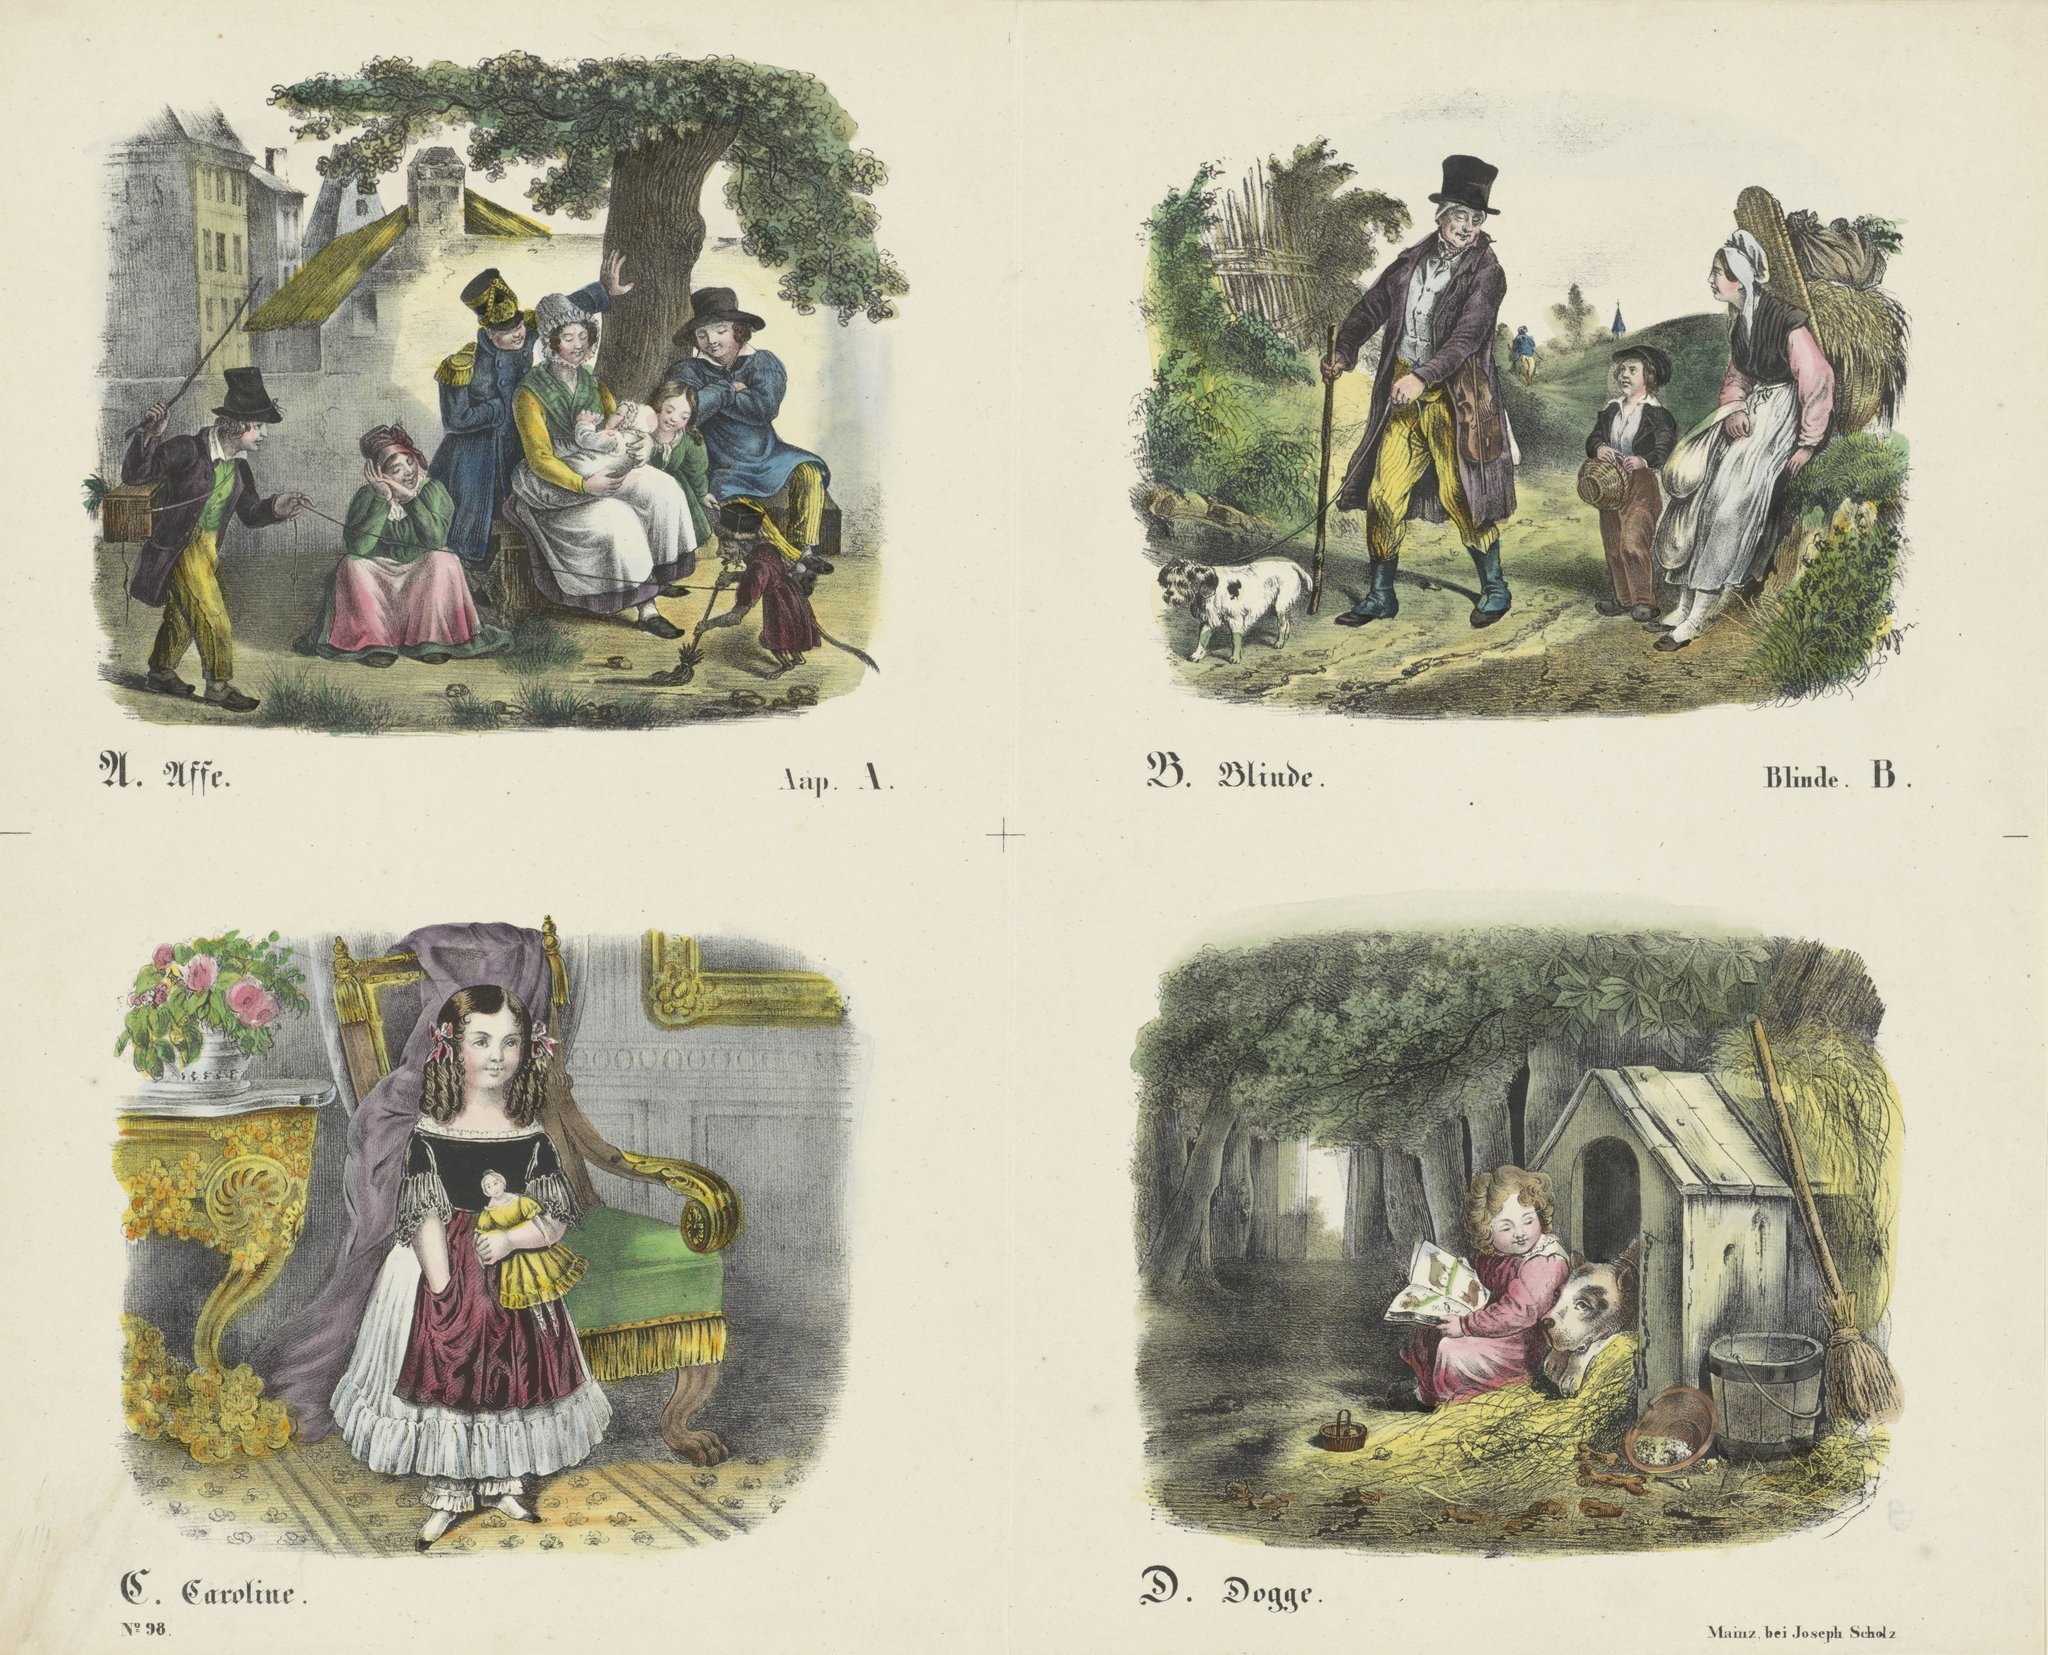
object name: popular print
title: Bilder A B C / Buch. / Prenten A B / Boek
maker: Anonymous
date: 1829-1880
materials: paper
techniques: colour, lithograph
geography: europe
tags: letters, alphabet, script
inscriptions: collector's mark: Lugt 2760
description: Blad met 4 voorstellingen om uit te knippen en samen tot boekje over het alfabet te binden. Verbeeldingen van de letters A (Aap), B (Blinde), C (Caroline) en D (Dogge = hond). Onder elke afbeelding een onderschrift in het Duits en in het Nederlands (behalve bij de letters C en D). Genummerd linksonder: No. 98.